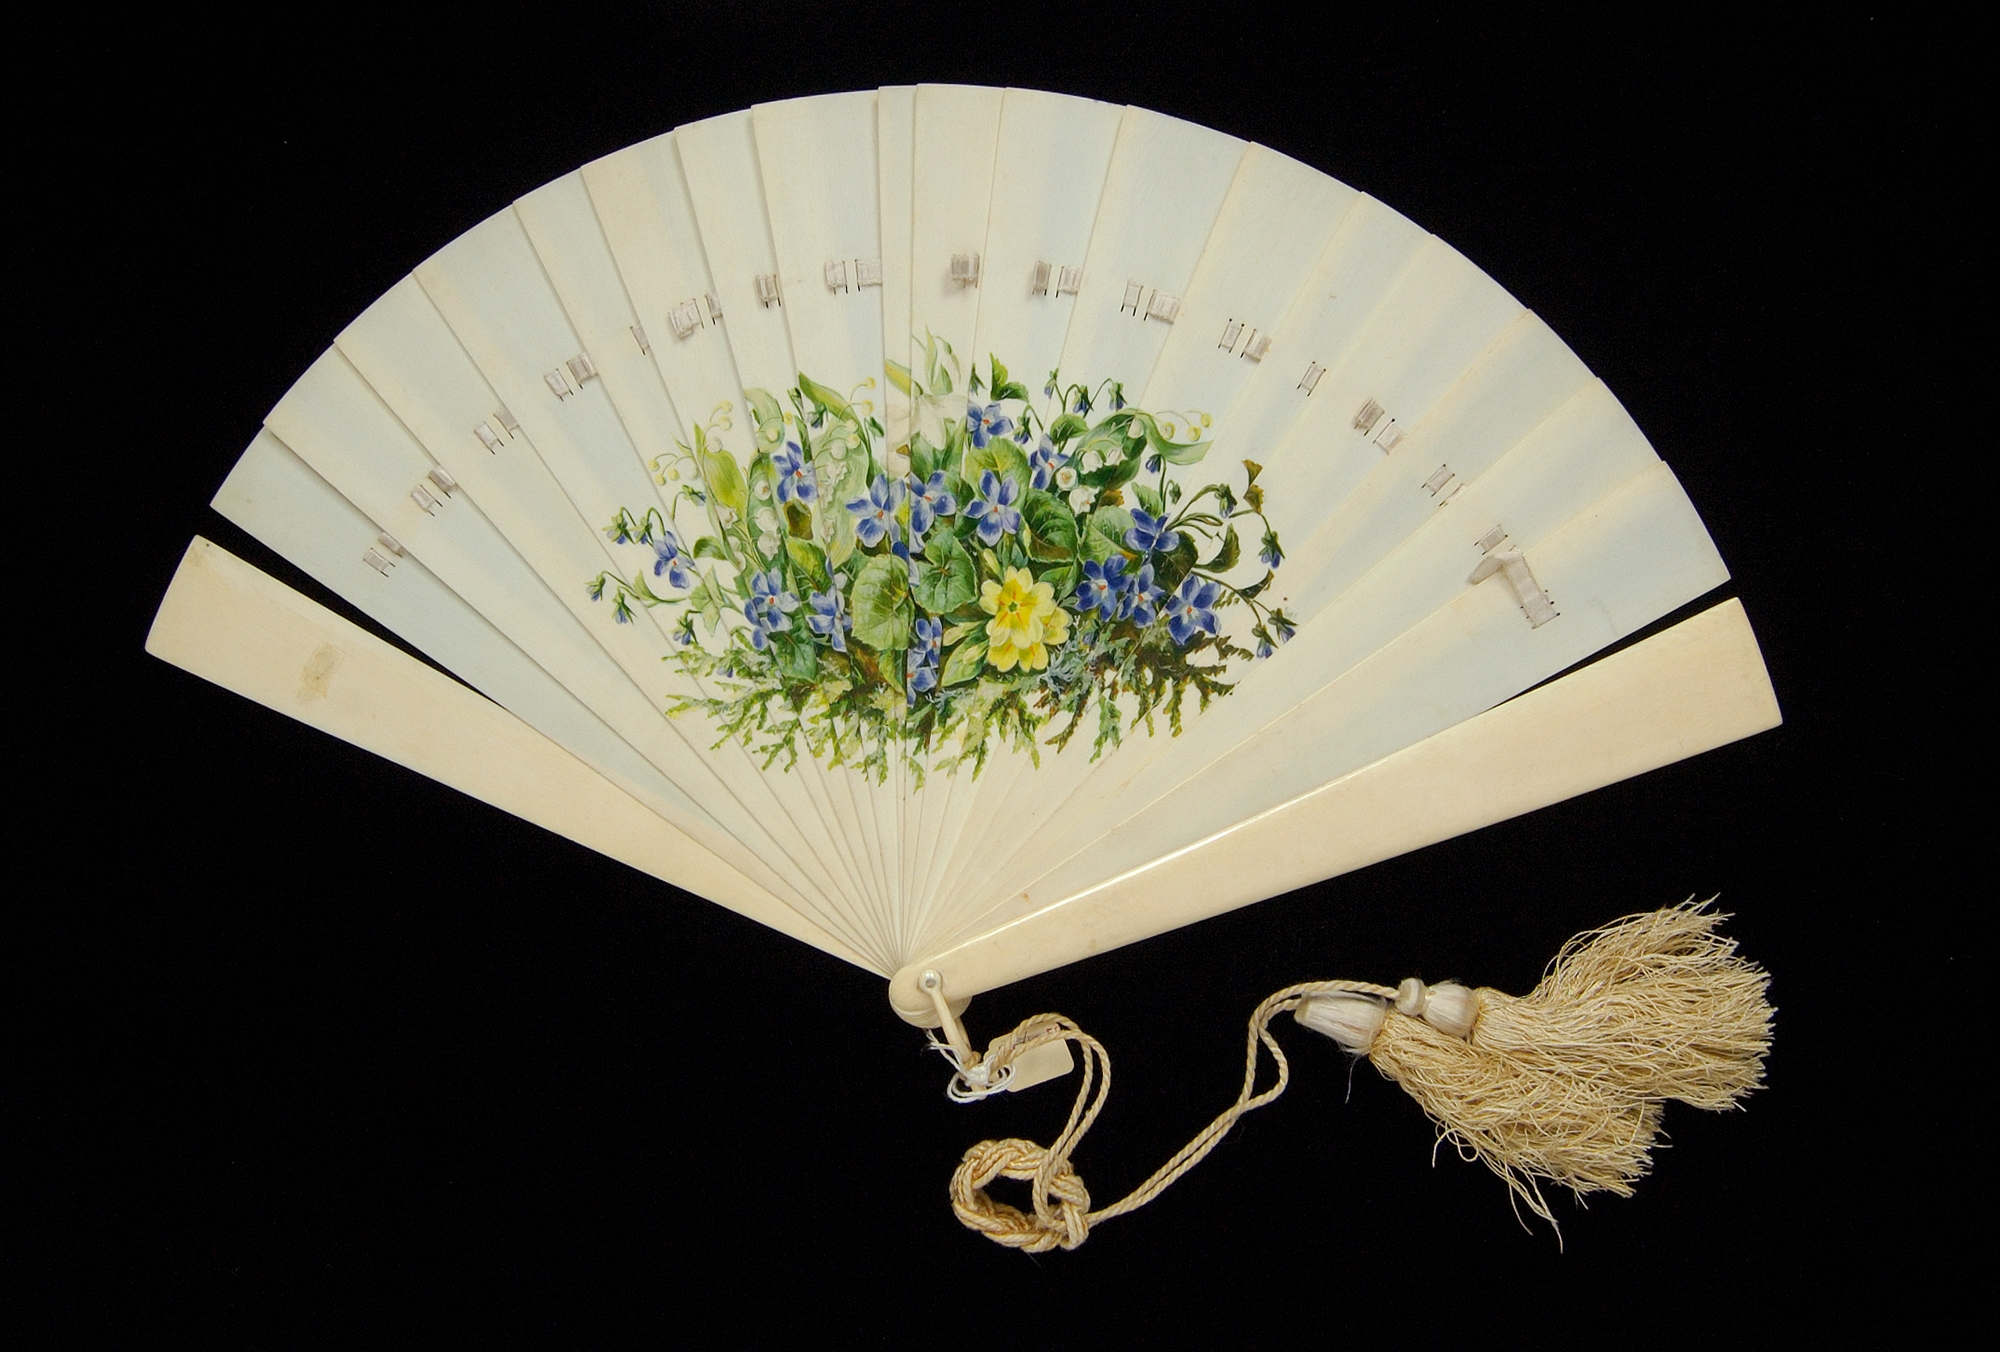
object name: brisé fan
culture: french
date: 1870-1890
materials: ivory, silk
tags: flowers